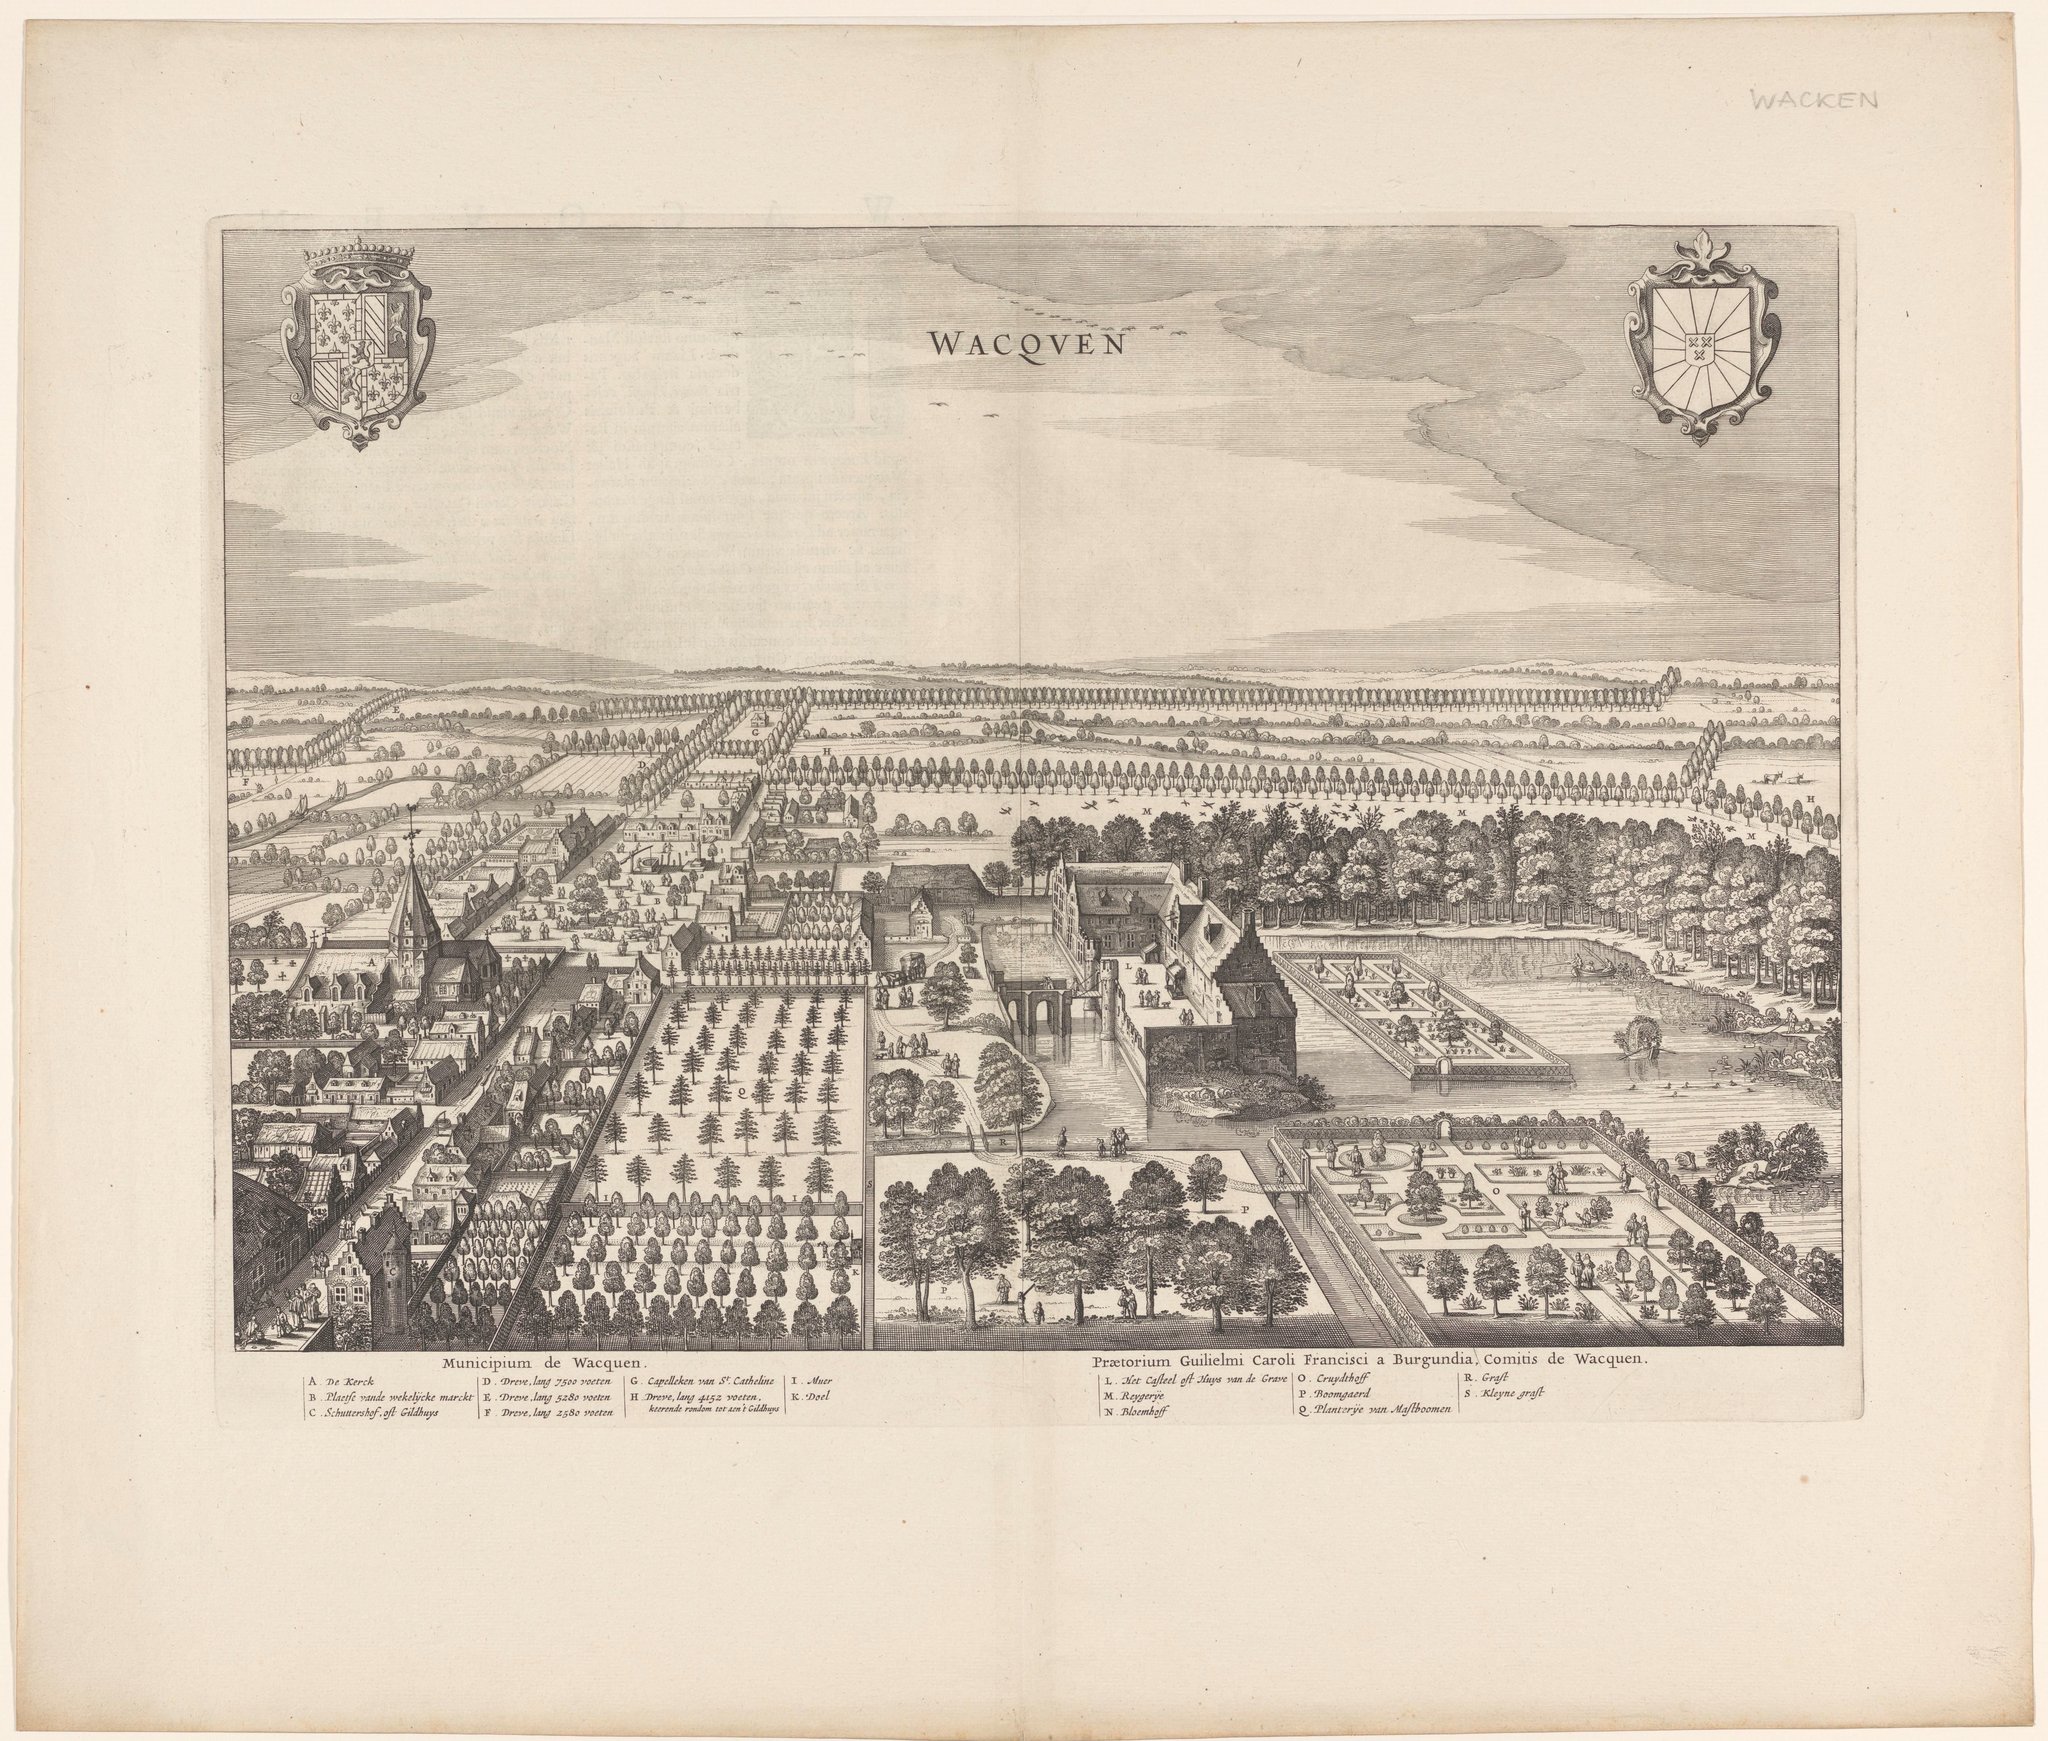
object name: print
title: Wacquen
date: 1652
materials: paper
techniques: engraving, etching, letterpress printing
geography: amsterdam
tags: prospect of village, silhouette of village, coat of arms (as symbol of the state, etc.) (+ city; municipal), castle, armorial bearing, heraldry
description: Gezicht op Wakken en het Kasteel van Wakken in vogelvluchtperspectief. Onder het gezicht op Wakken een legenda A-S. Linksboven het wapen van Bourgondië. Rechtsboven het wapen Wakken. Met Latijnse tekst op verso.